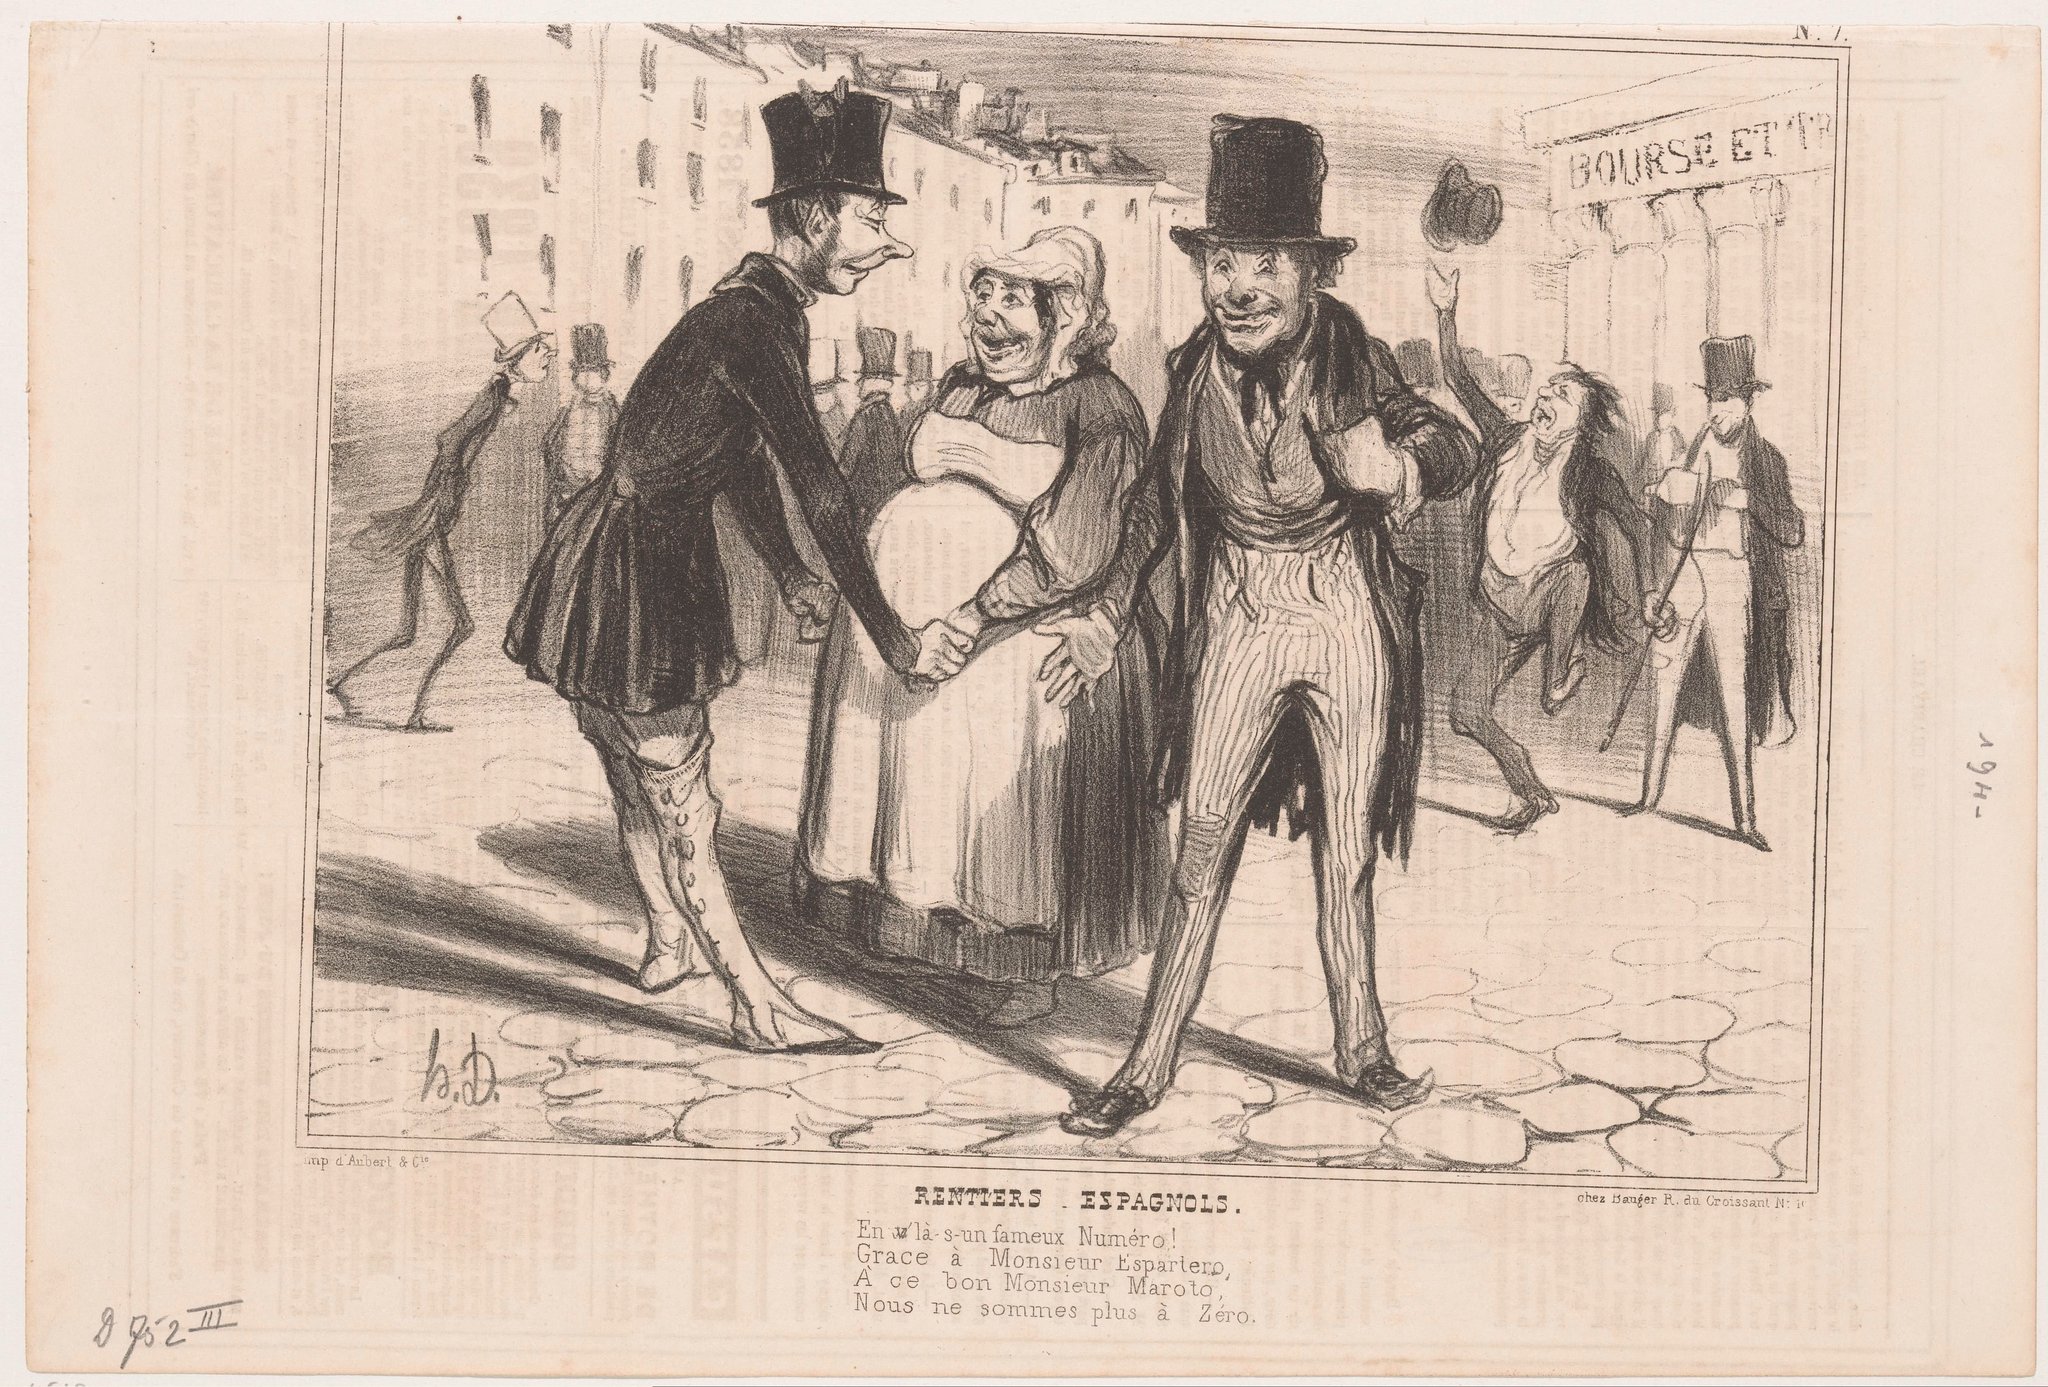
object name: cartoon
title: Drie Spaanse lijfrentetrekkers uiten hun succes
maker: honoré daumier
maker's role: draughtsman, painter, print maker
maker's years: 1808-1879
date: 1839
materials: paper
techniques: letterpress printing, lithograph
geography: paris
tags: europeans: spaniards, caricatures (human types), stock exchange, stock-market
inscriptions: collector's mark: Lugt 2228a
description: Prent mogelijk voor: Le Charivari, 13 oktober 1839.